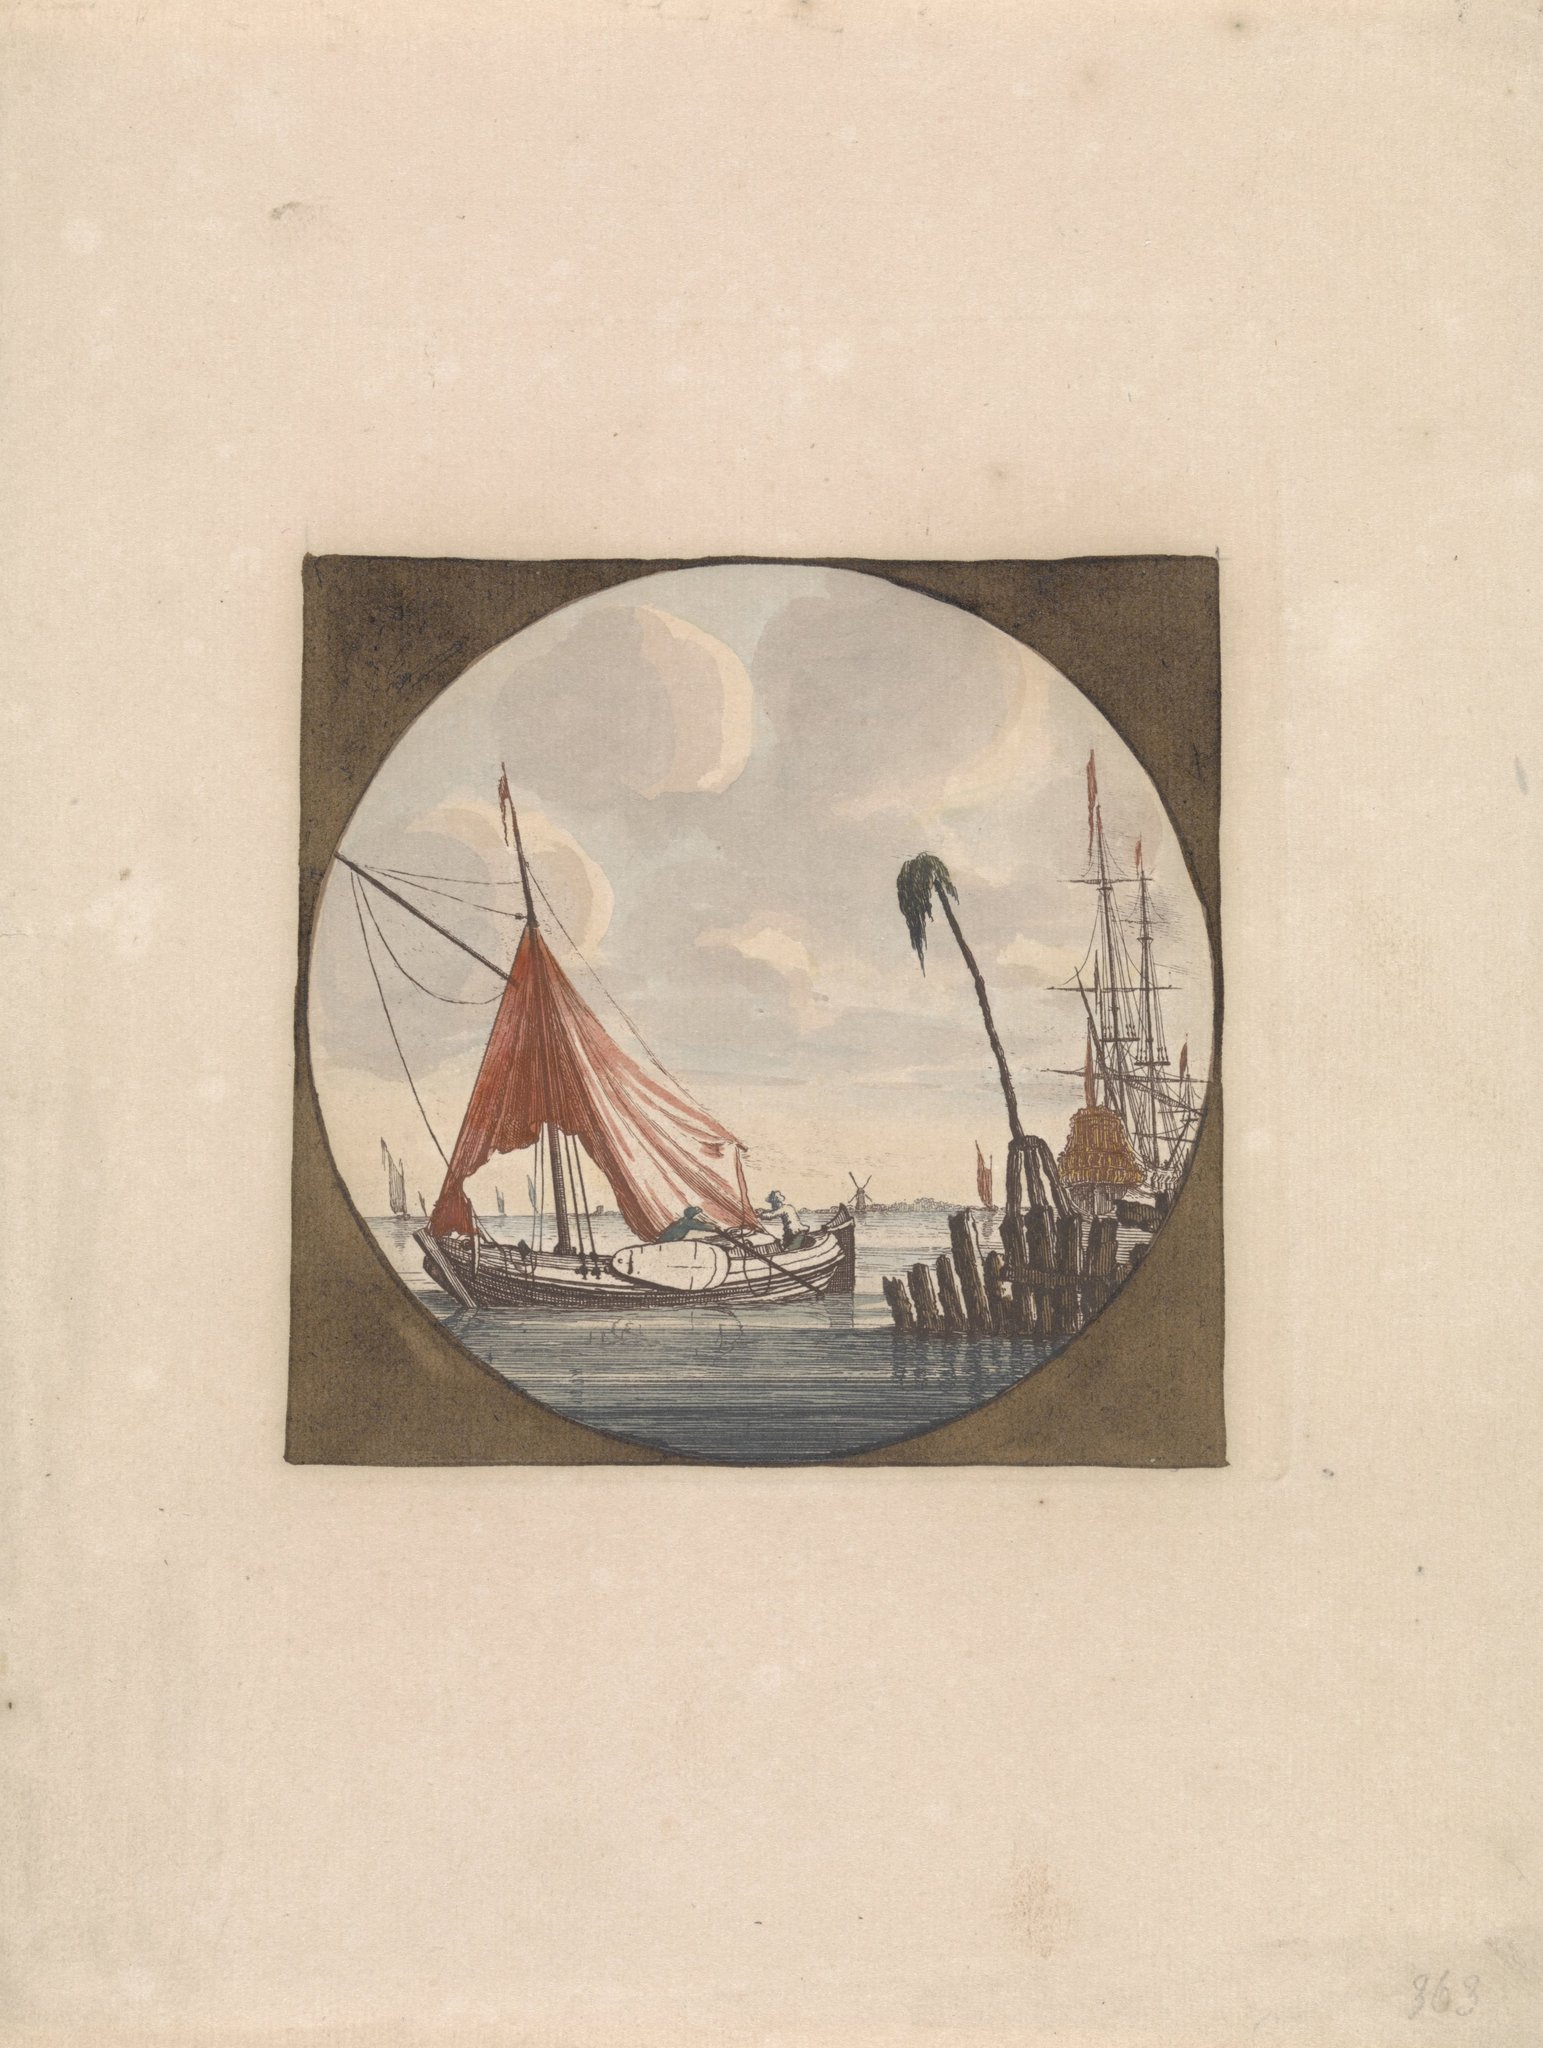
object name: print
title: Schepen op zee (serie B)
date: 1688-1750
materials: paper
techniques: etching, hand coloring, lithography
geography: netherlands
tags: sailing-ship, sailing-boat, sea (seascape)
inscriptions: collector's mark: Lugt 2228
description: Van een zeilschip, dat links van enkele meerpalen ligt, wordt het roodbruine zeil door een man gehesen. Een andere man steekt de vaarboom in het water. Op de achtergrond andere zeilschepen.